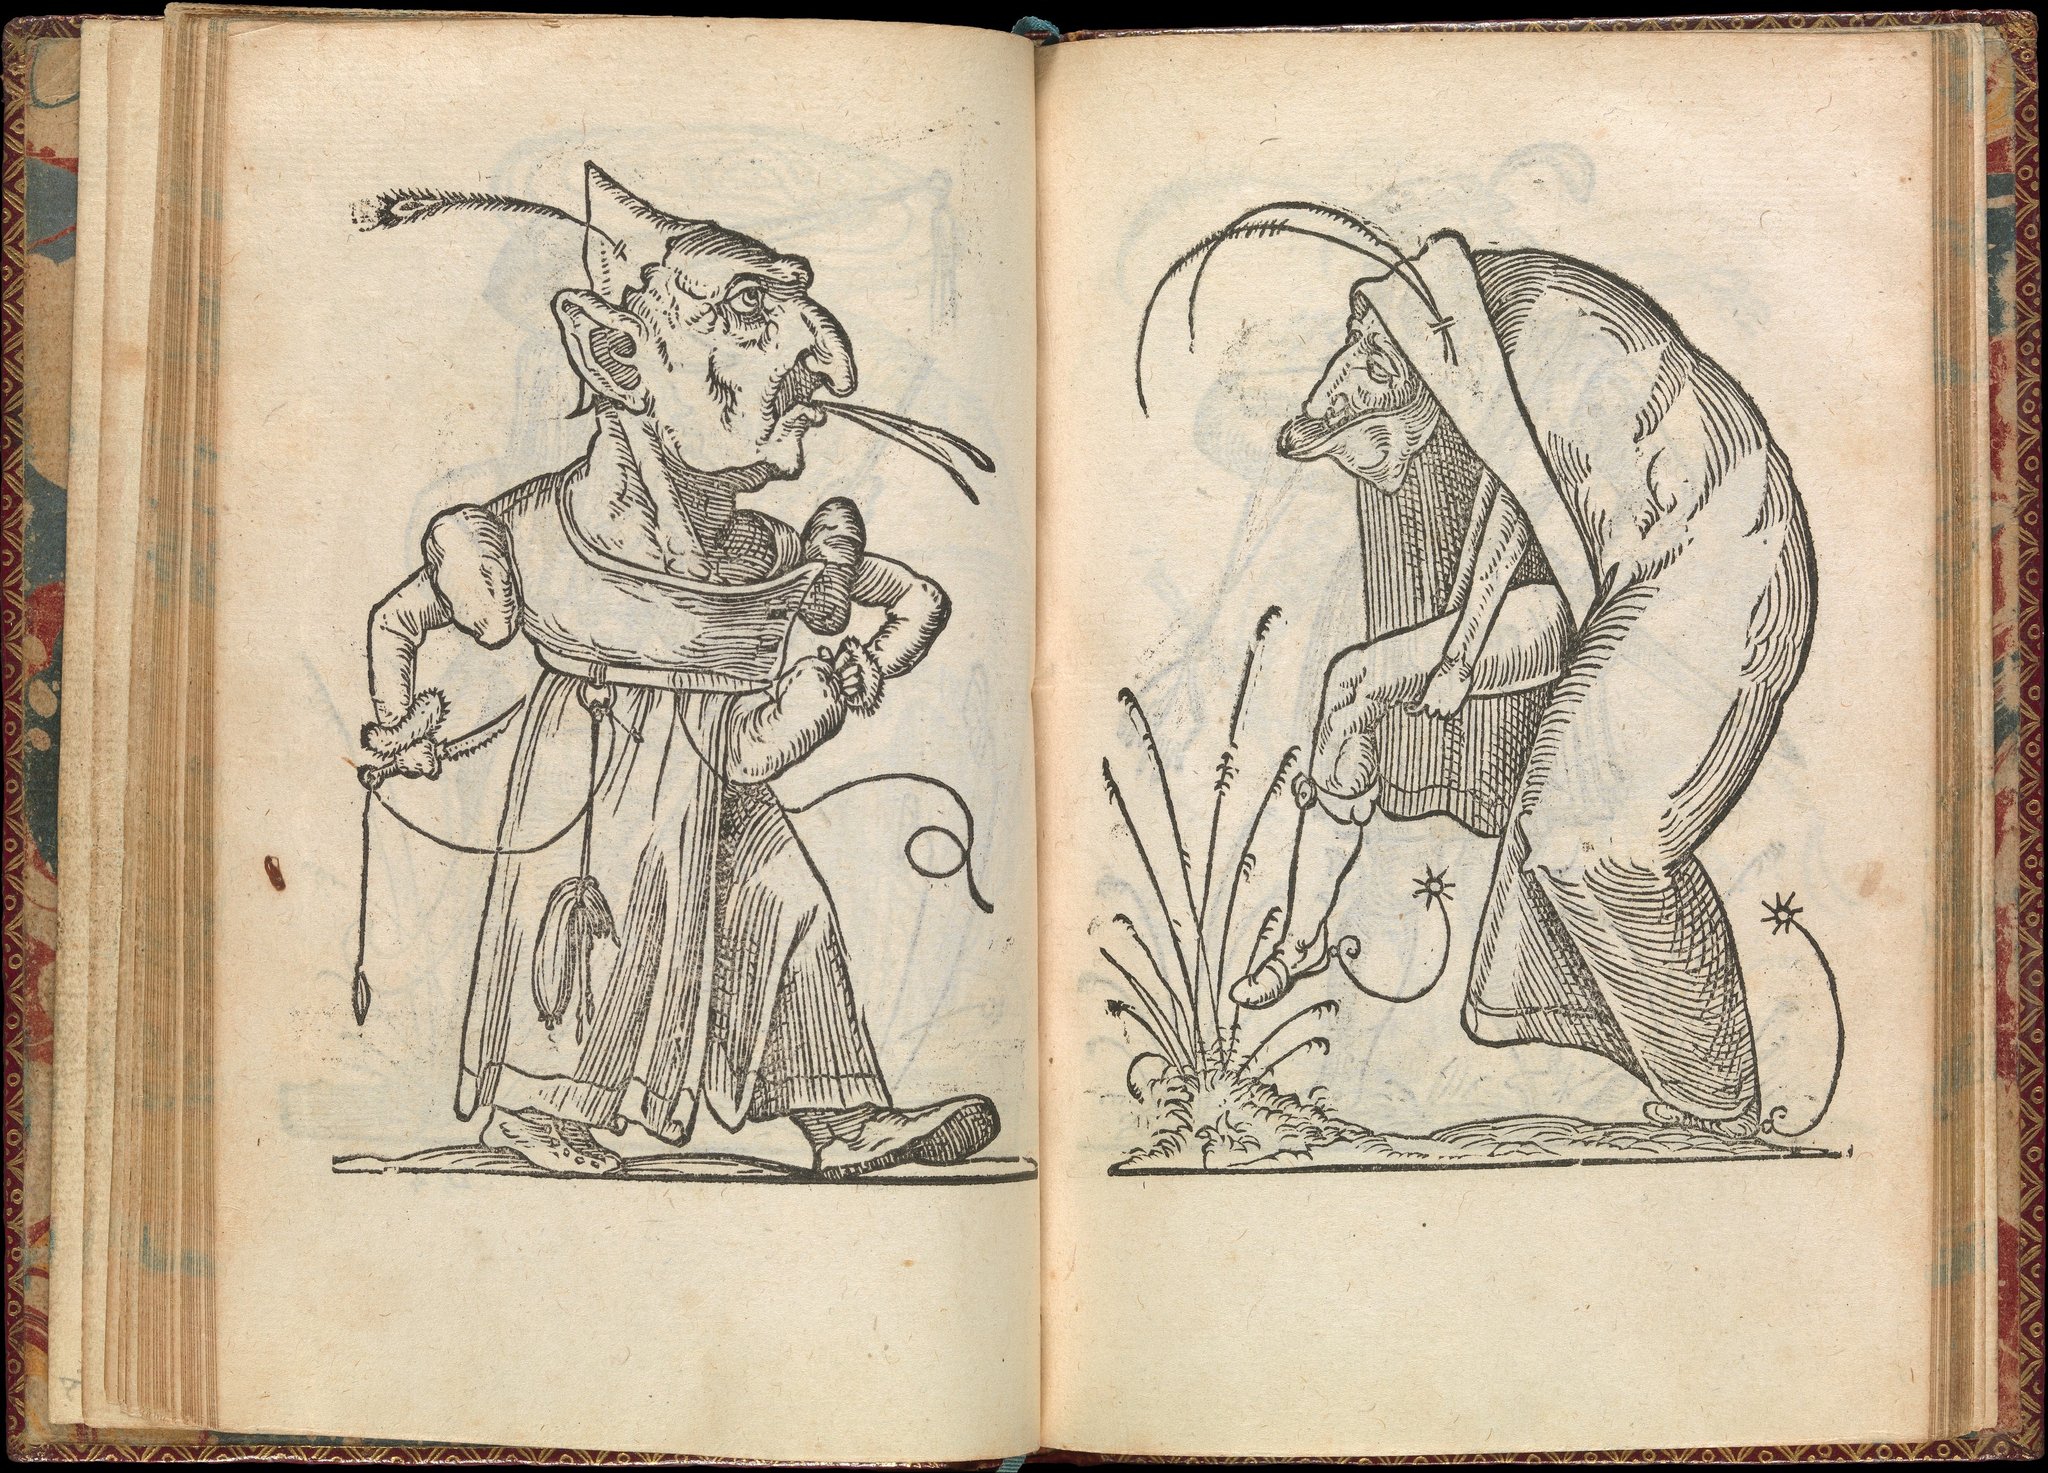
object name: book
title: Les Songes Drolatiques de Pantagruel ou sont contenues plusieurs figures de l'invention de maitre François Rabelais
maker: françois desprez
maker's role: artist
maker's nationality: french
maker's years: 1500-1600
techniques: letterpress, woodcut